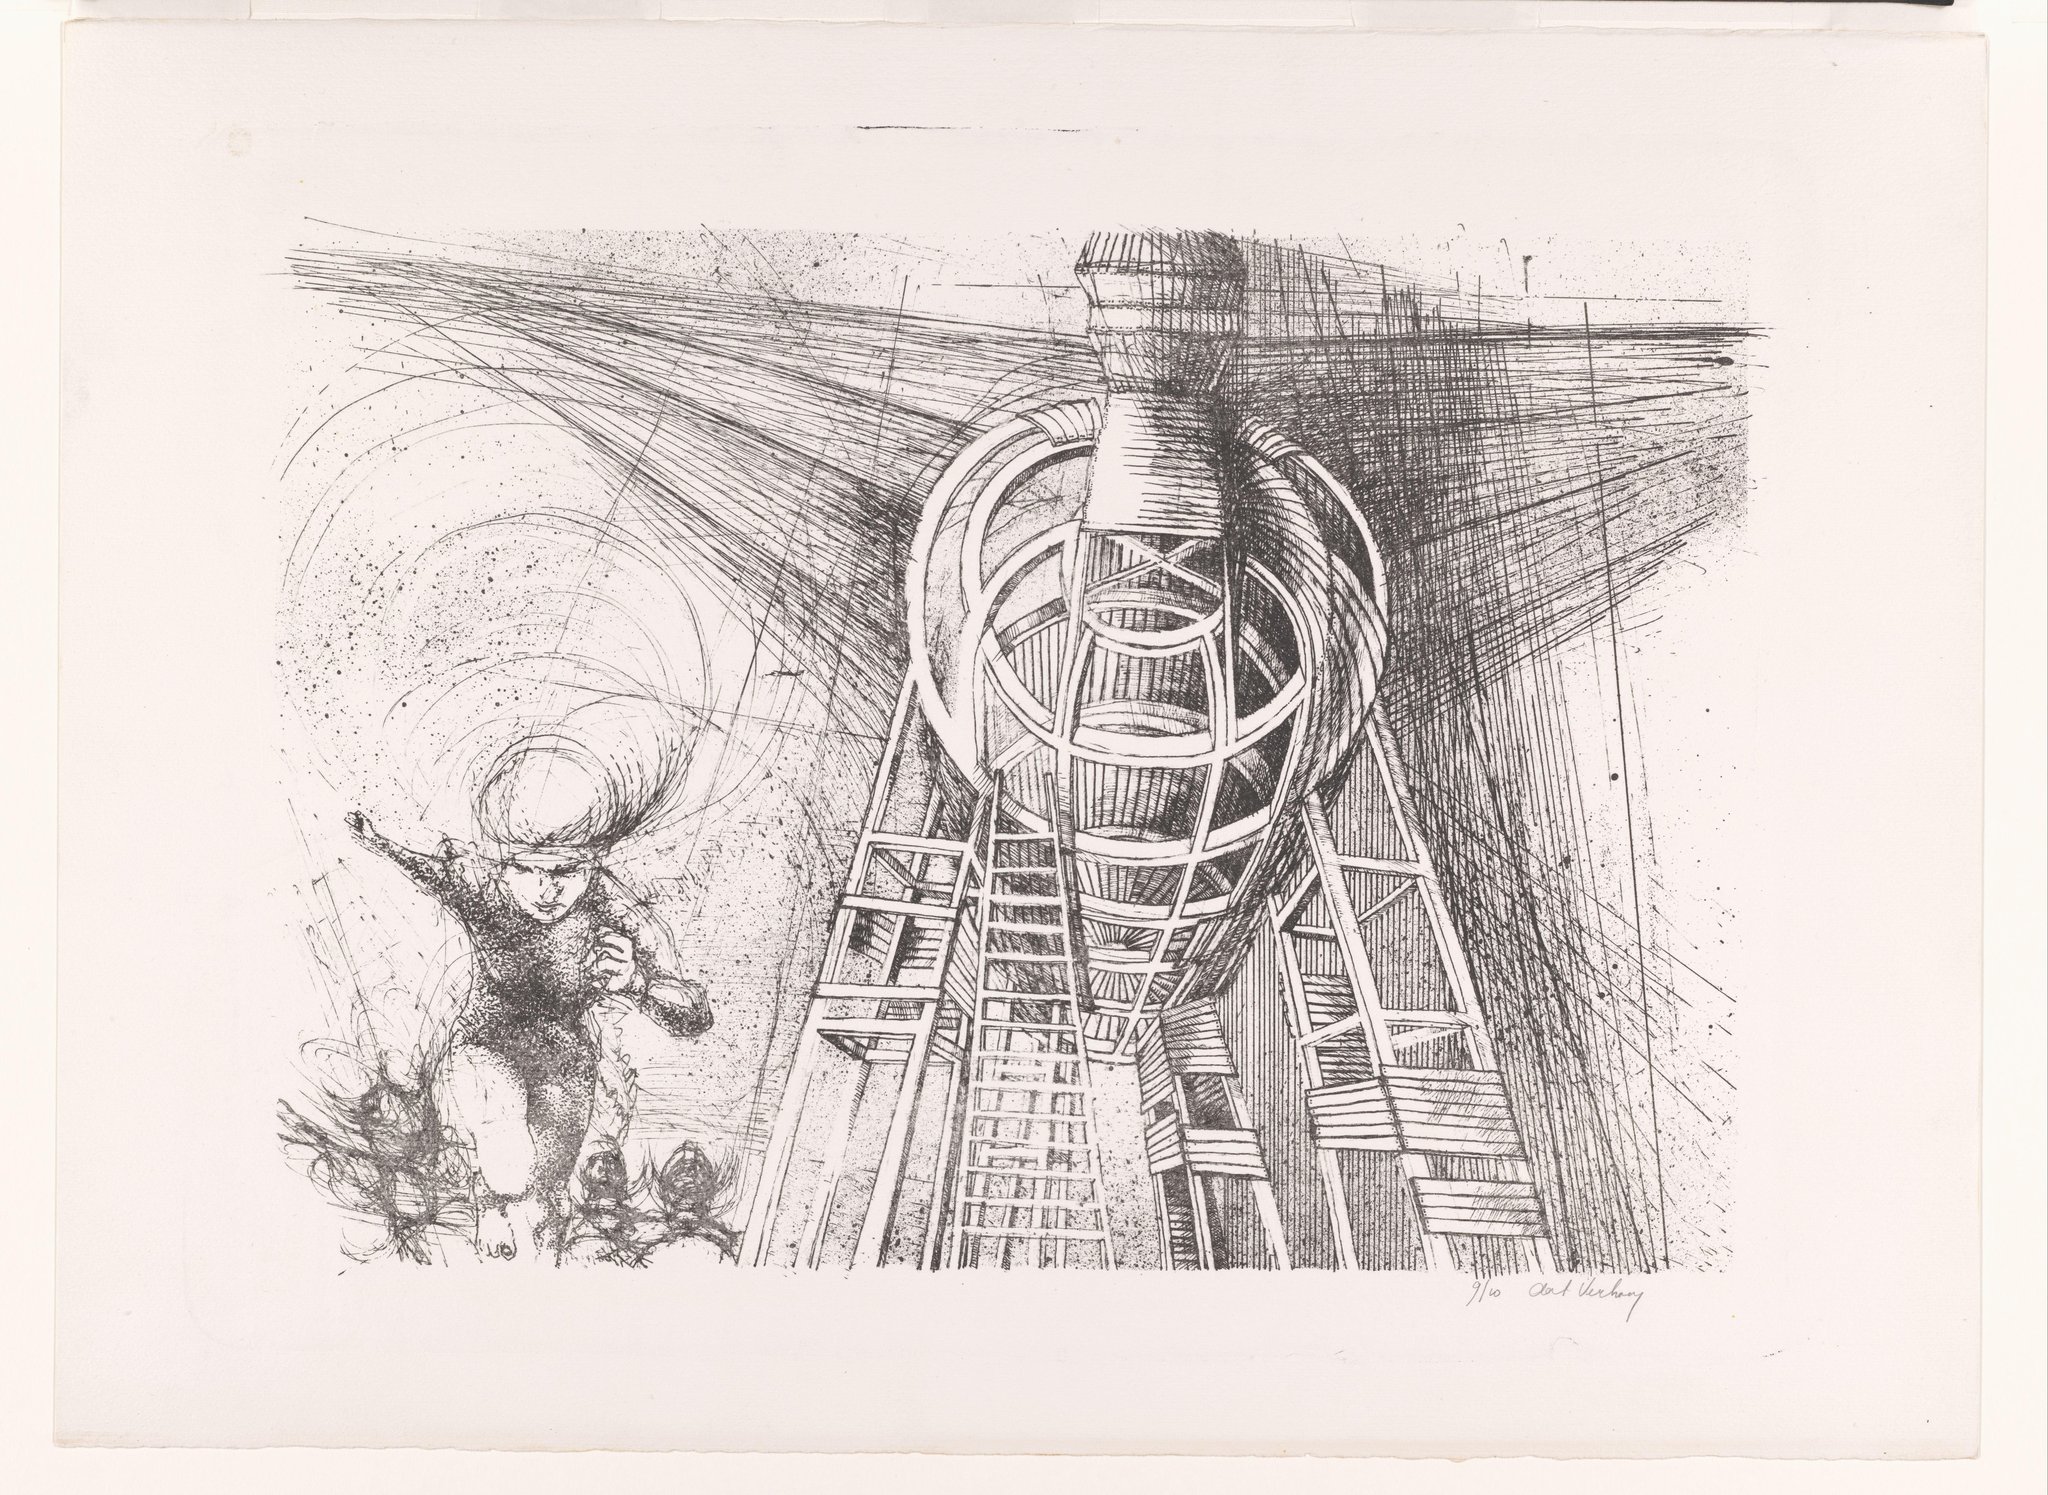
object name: print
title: De bouw van het paard van Troje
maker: aat verhoog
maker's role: print maker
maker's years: 1933-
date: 1965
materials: paper, ink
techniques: etching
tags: the building of the wooden horse with minerva's help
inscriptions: edition: ‘9/10’, signature: ‘Aat Verhoog’, title: ‘Aat Verhoog/ "De bouw van het paard van Troje"’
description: Rechts een houten stellage in de vorm van een paard, links een rennend figuur frontaal gezien.